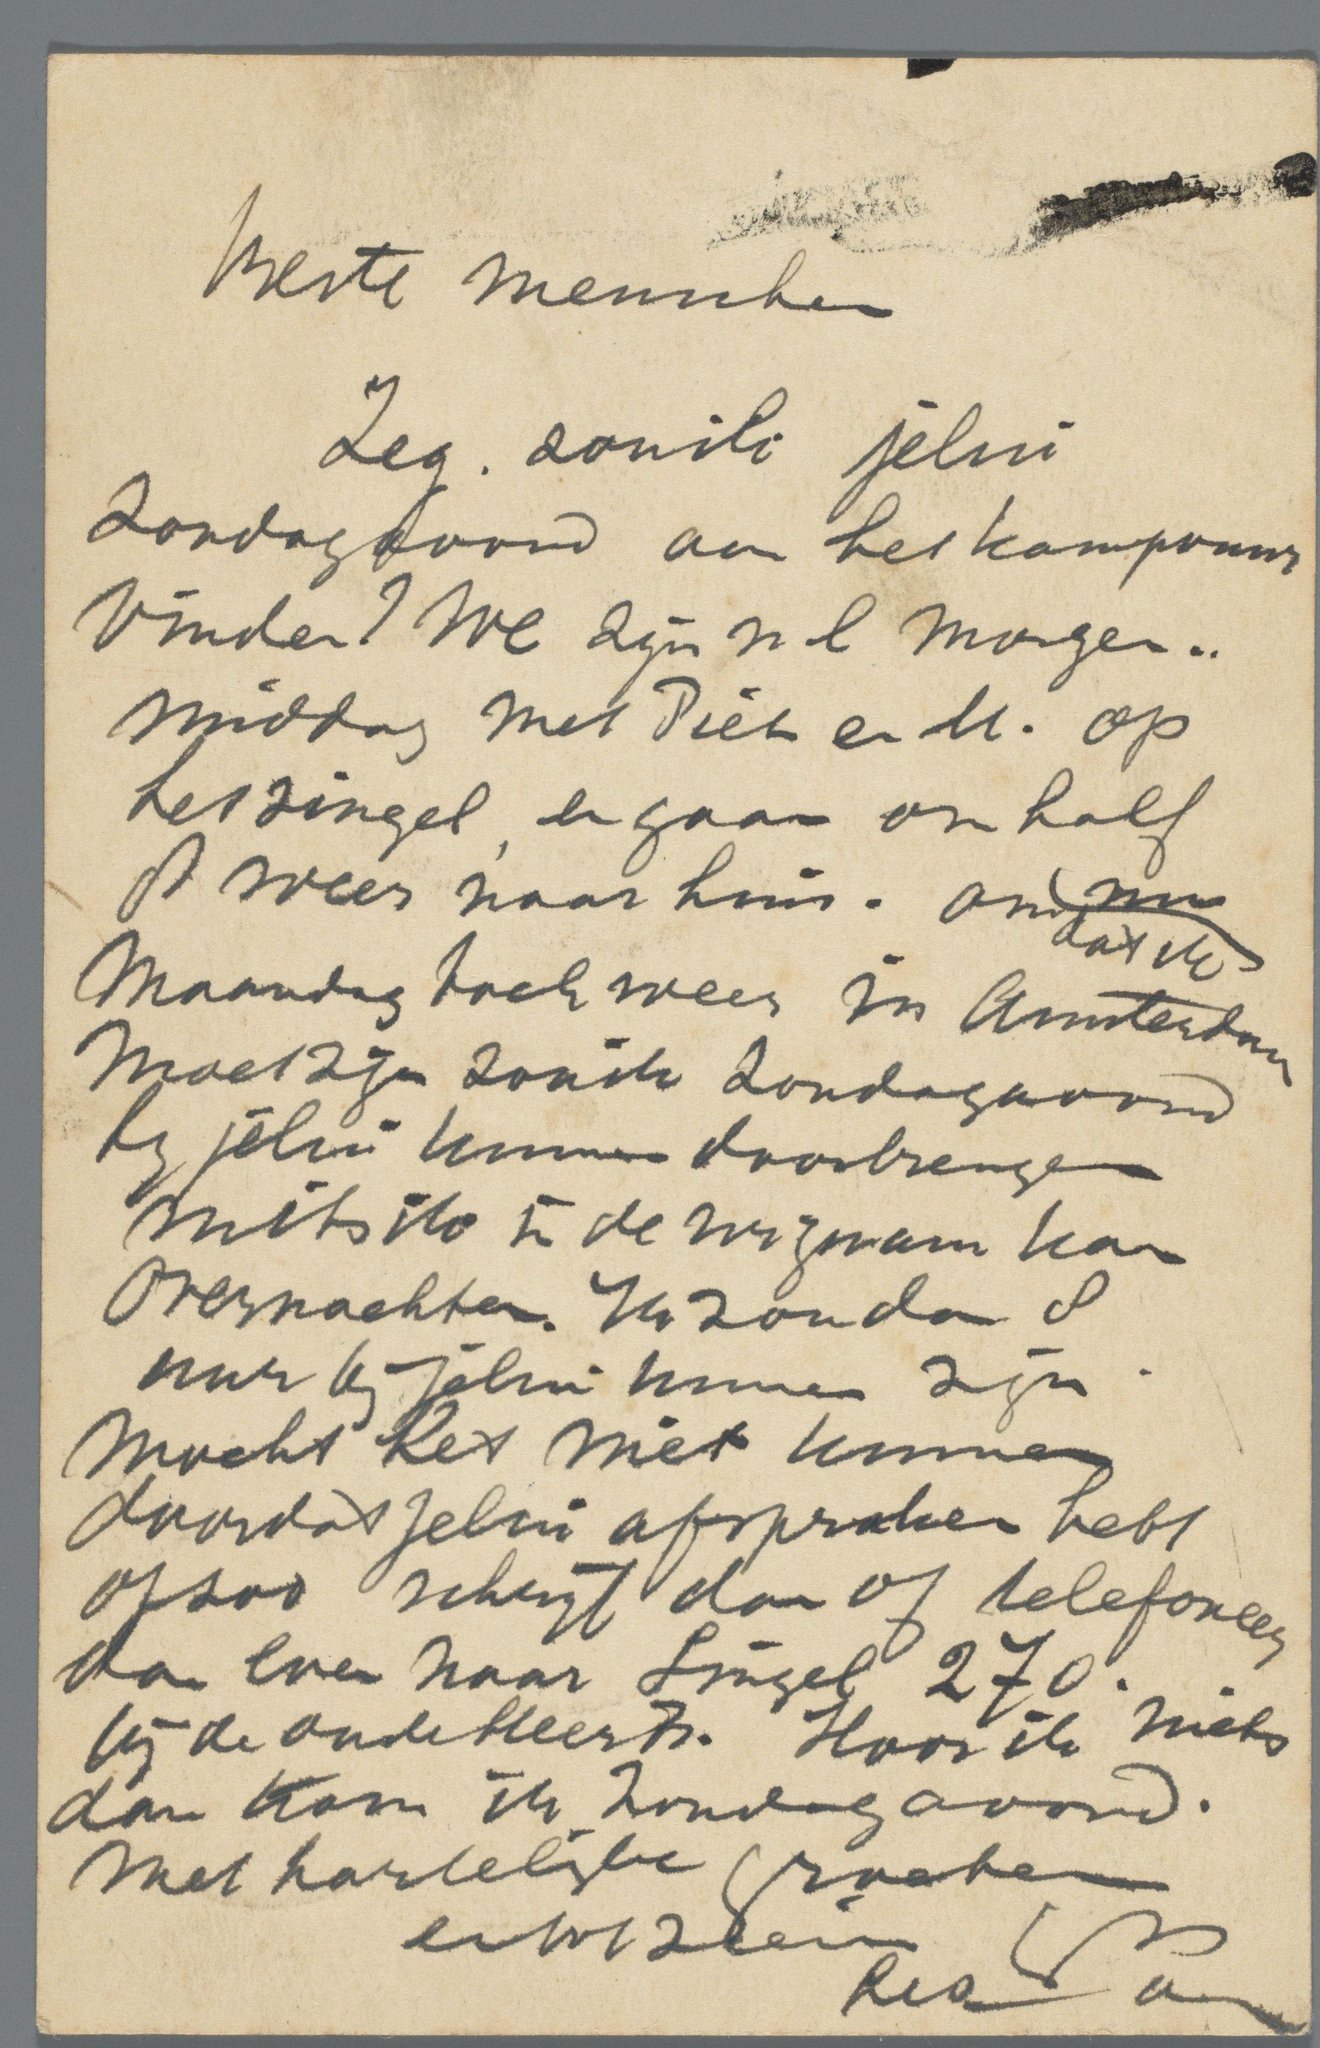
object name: drawing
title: Briefkaart aan Jan Ponstijn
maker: leo gestel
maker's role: draughtsman, print maker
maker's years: 1881-1941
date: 1919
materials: cardboard, ink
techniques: pen, writing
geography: bergen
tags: amsterdam, draughtsman, jan petrus ponstijn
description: Briefkaart met een tekening, mogelijk van een figuur in een boot. Briefkaart maakt deel uit van een album.